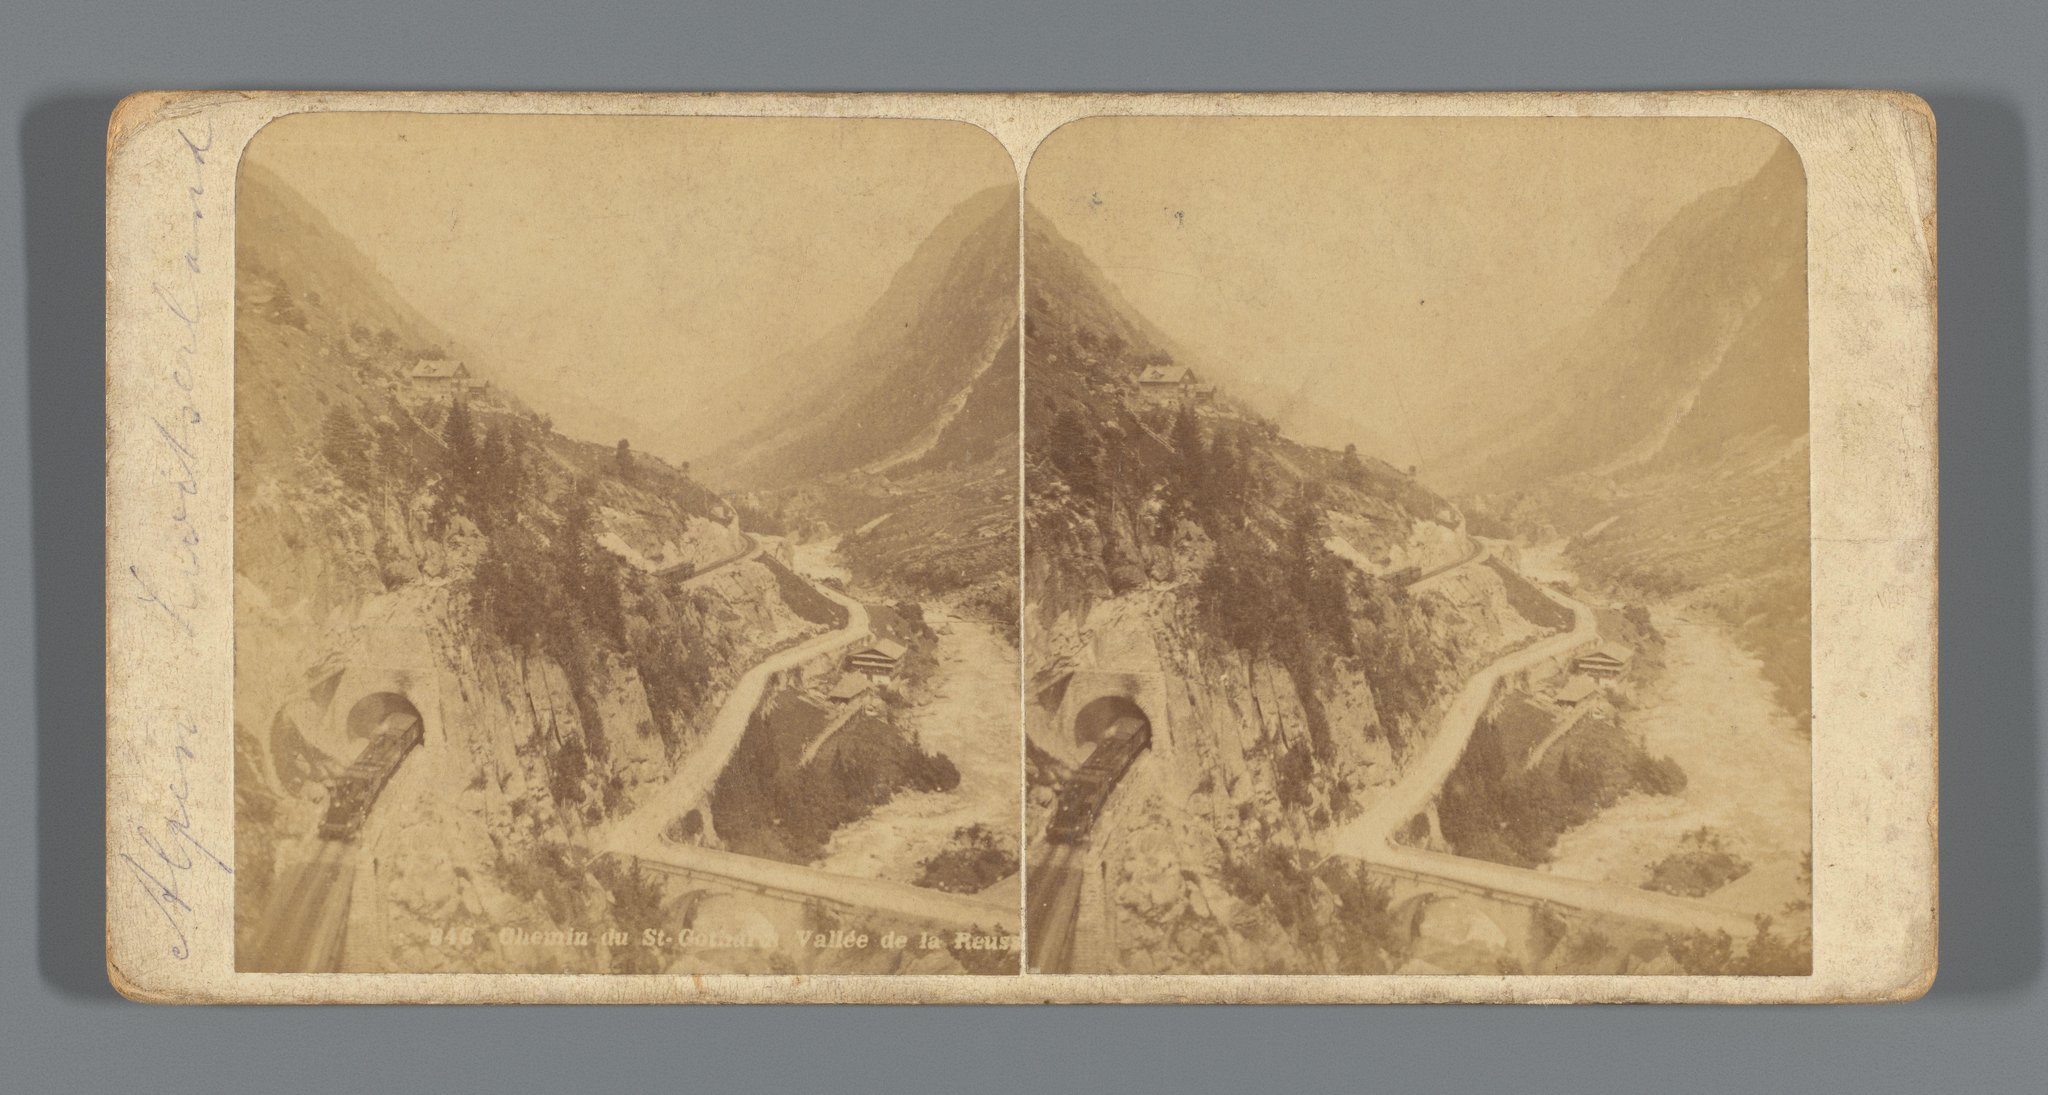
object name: stereograph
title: Aardrijkskundige Beeldengalerij, verzameld door M.J. Broekhuijsen, Hoofd eener school te Amsterdam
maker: martien johan broekhuijsen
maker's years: 1871-1956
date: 1905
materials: photographic support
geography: amsterdam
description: Onderdeel van een groep van 52 stereofoto's gebruikt in het lager onderwijs als aanvulling op schoolplaten. De gehele reeks bestond uit 274 nummers in 10 categorieën (A t/m K).